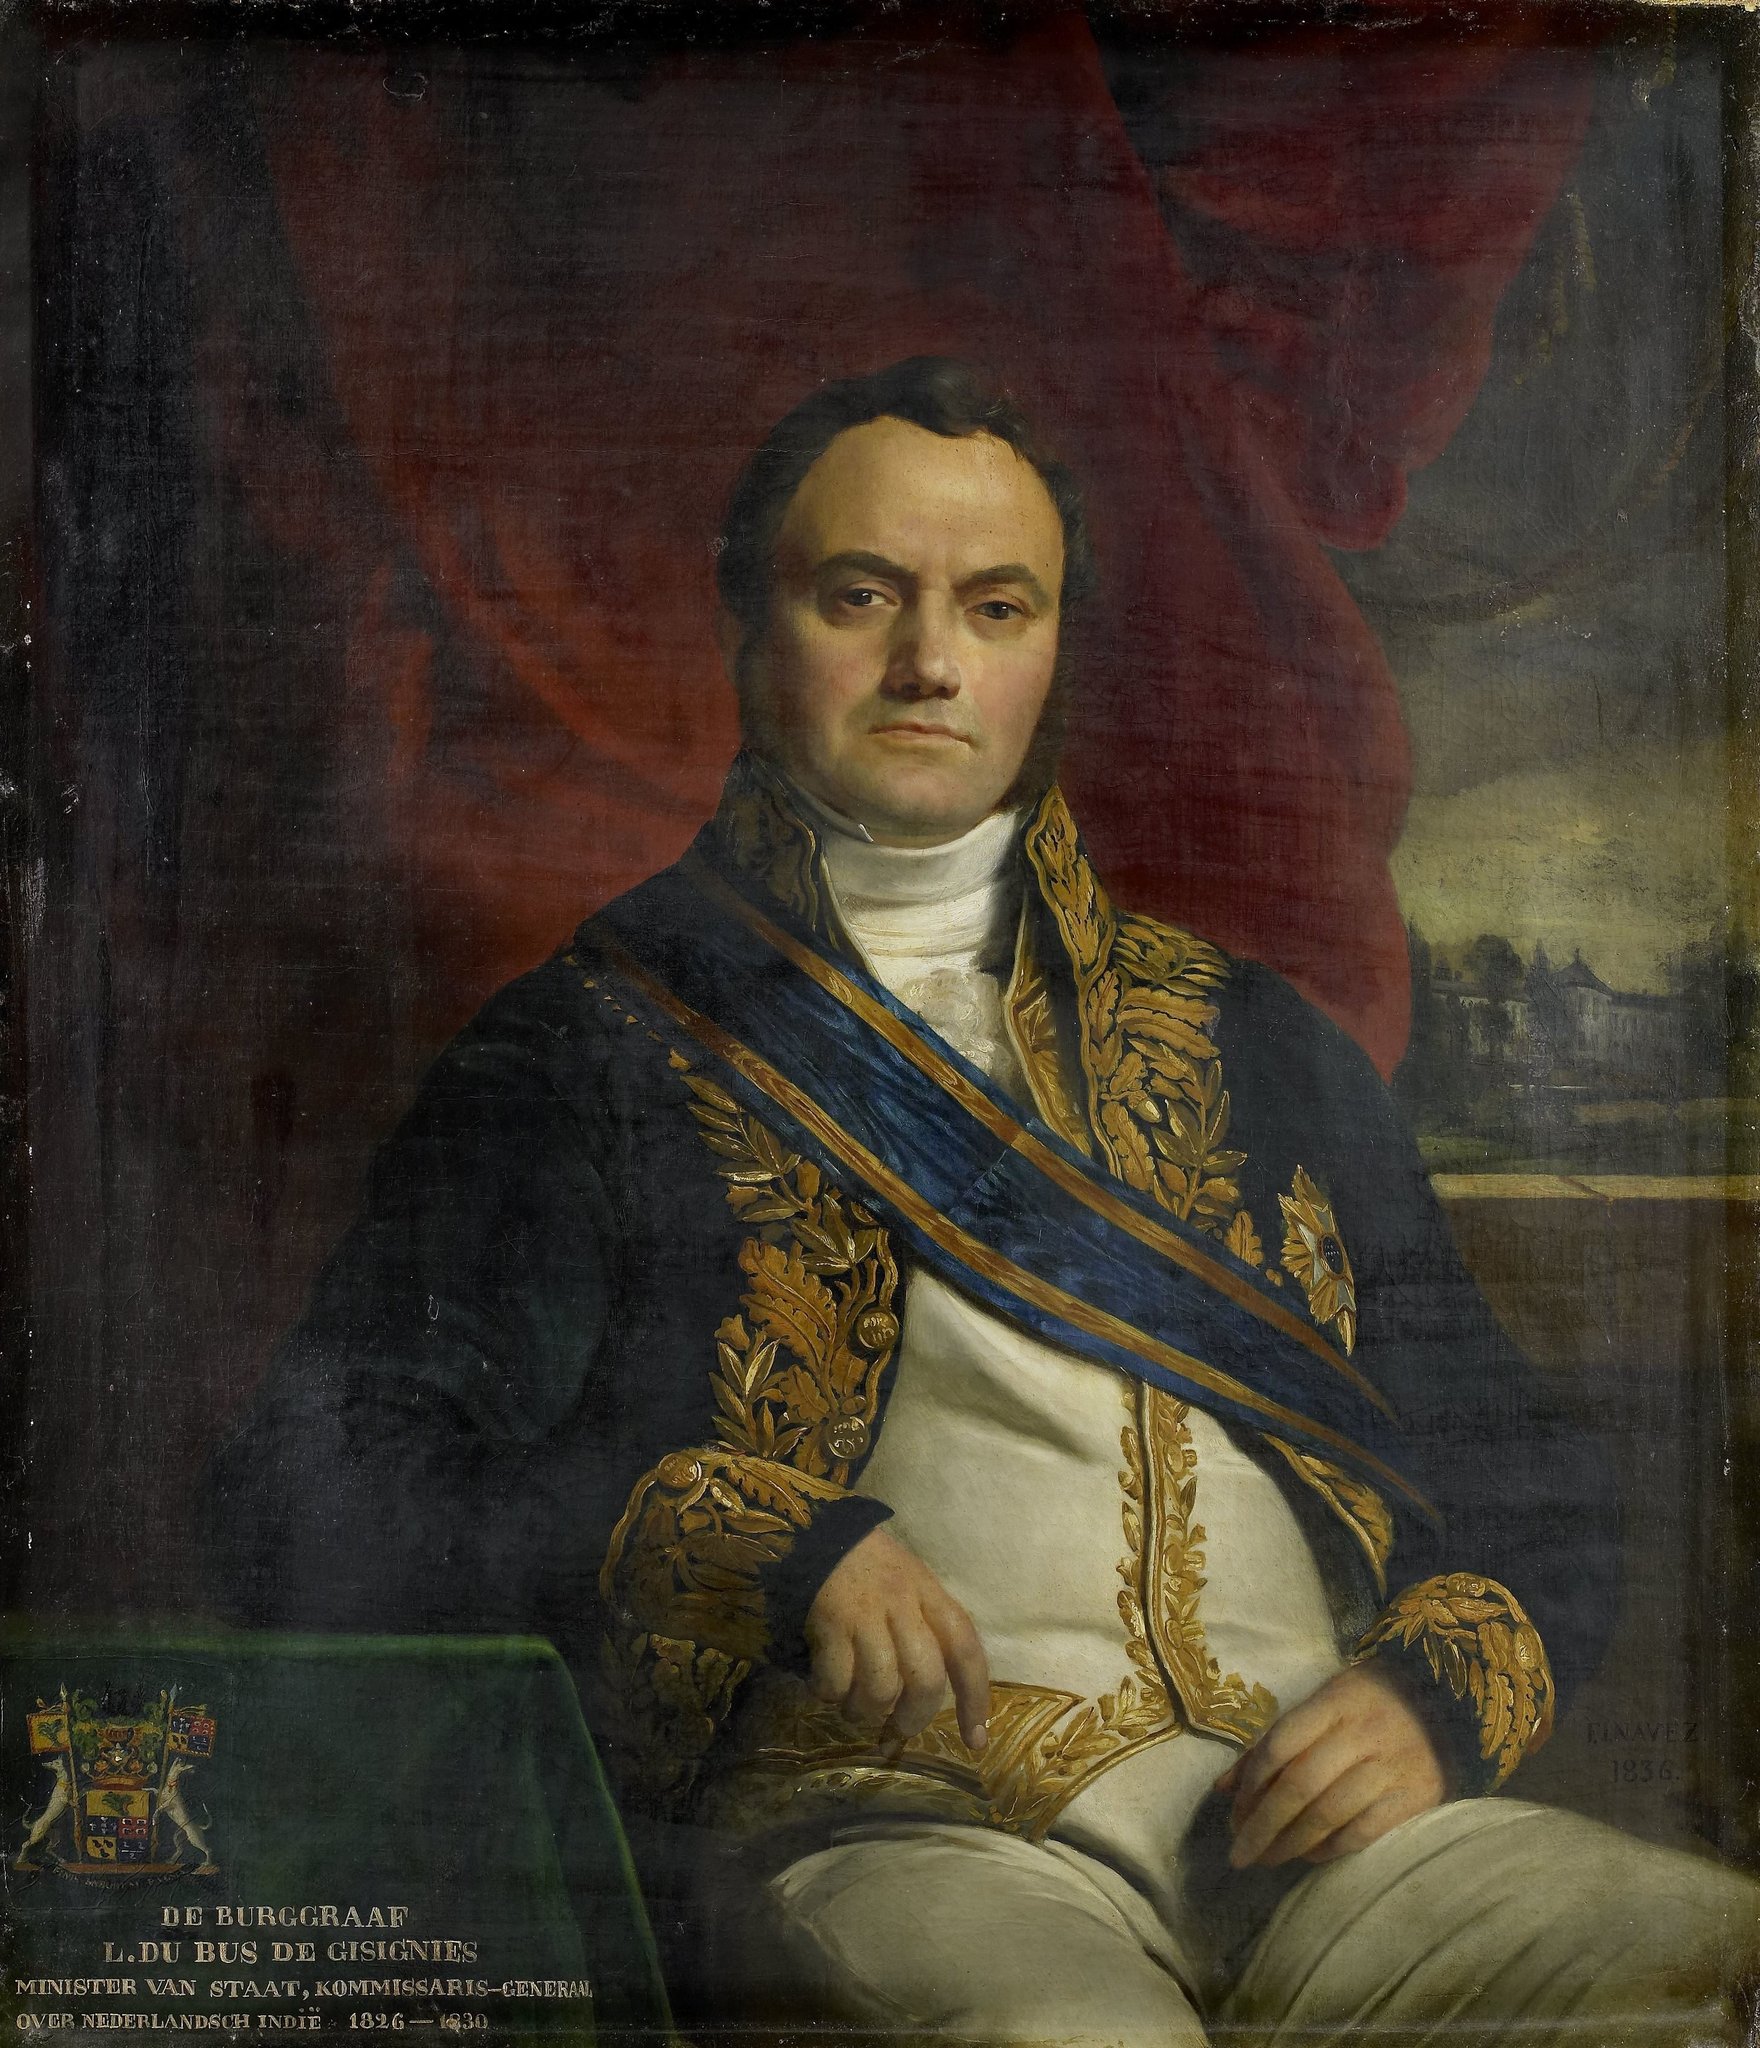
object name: painting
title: Portrait of Léonard Pierre Joseph, Viscount du Bus de Gisignies, Commissioner-General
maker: françois joseph navez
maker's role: draughtsman, painter, print maker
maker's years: 1787-1869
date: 1836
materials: canvas, oil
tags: colonial governor, historical persons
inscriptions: signature and date: ‘F.I. Navez. 1836’, inscription: ‘De Burggraaf L. Du Bus de Gisignies. Minister van Staat, Kommissaris-Generaal over Nederlandsch Indië 1826-30.’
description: Portret van Léonard Pierre Joseph Burgrave du Bus de Gisignies (1780-1849). Commissaris-generaal (1826-30). Kniestuk, zittend in een stoel, iets naar rechts, met de rechterarm geleund op een tafel. Over de balustrade rechts op de achtergrond een landschap met een landhuis. Onderdeel van een reeks van portretten van de gouverneurs-generaal van het voormalige Nederlands Oost-Indië.